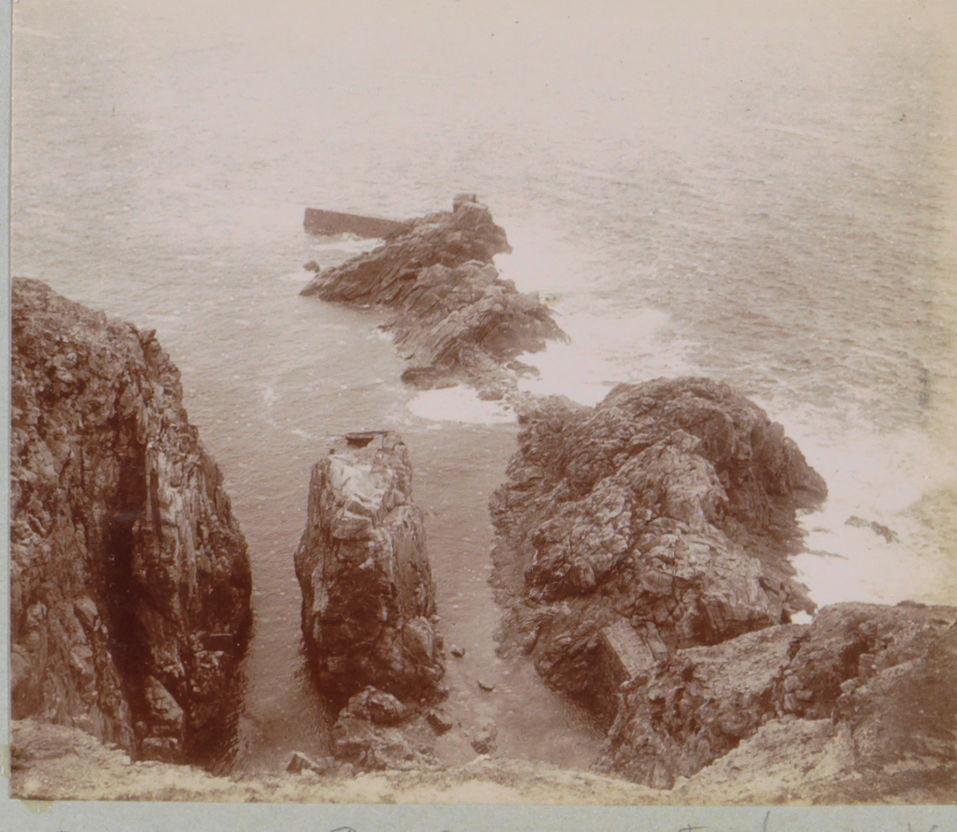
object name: photograph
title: Gezicht op de haven van Bestrée bij de Pointe du Raz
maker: delizy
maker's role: manufacturer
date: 1901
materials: paper, photographic support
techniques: gelatin silver print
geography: pointe du raz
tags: harbour, coastal cliff or crag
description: Onderdeel van Fotoalbum van een Franse amateurfotograaf met opnames van uitstapjes in Frankrijk, Spanje, België, Luxemburg en Nederland, de eerste automobielen en autoraces.